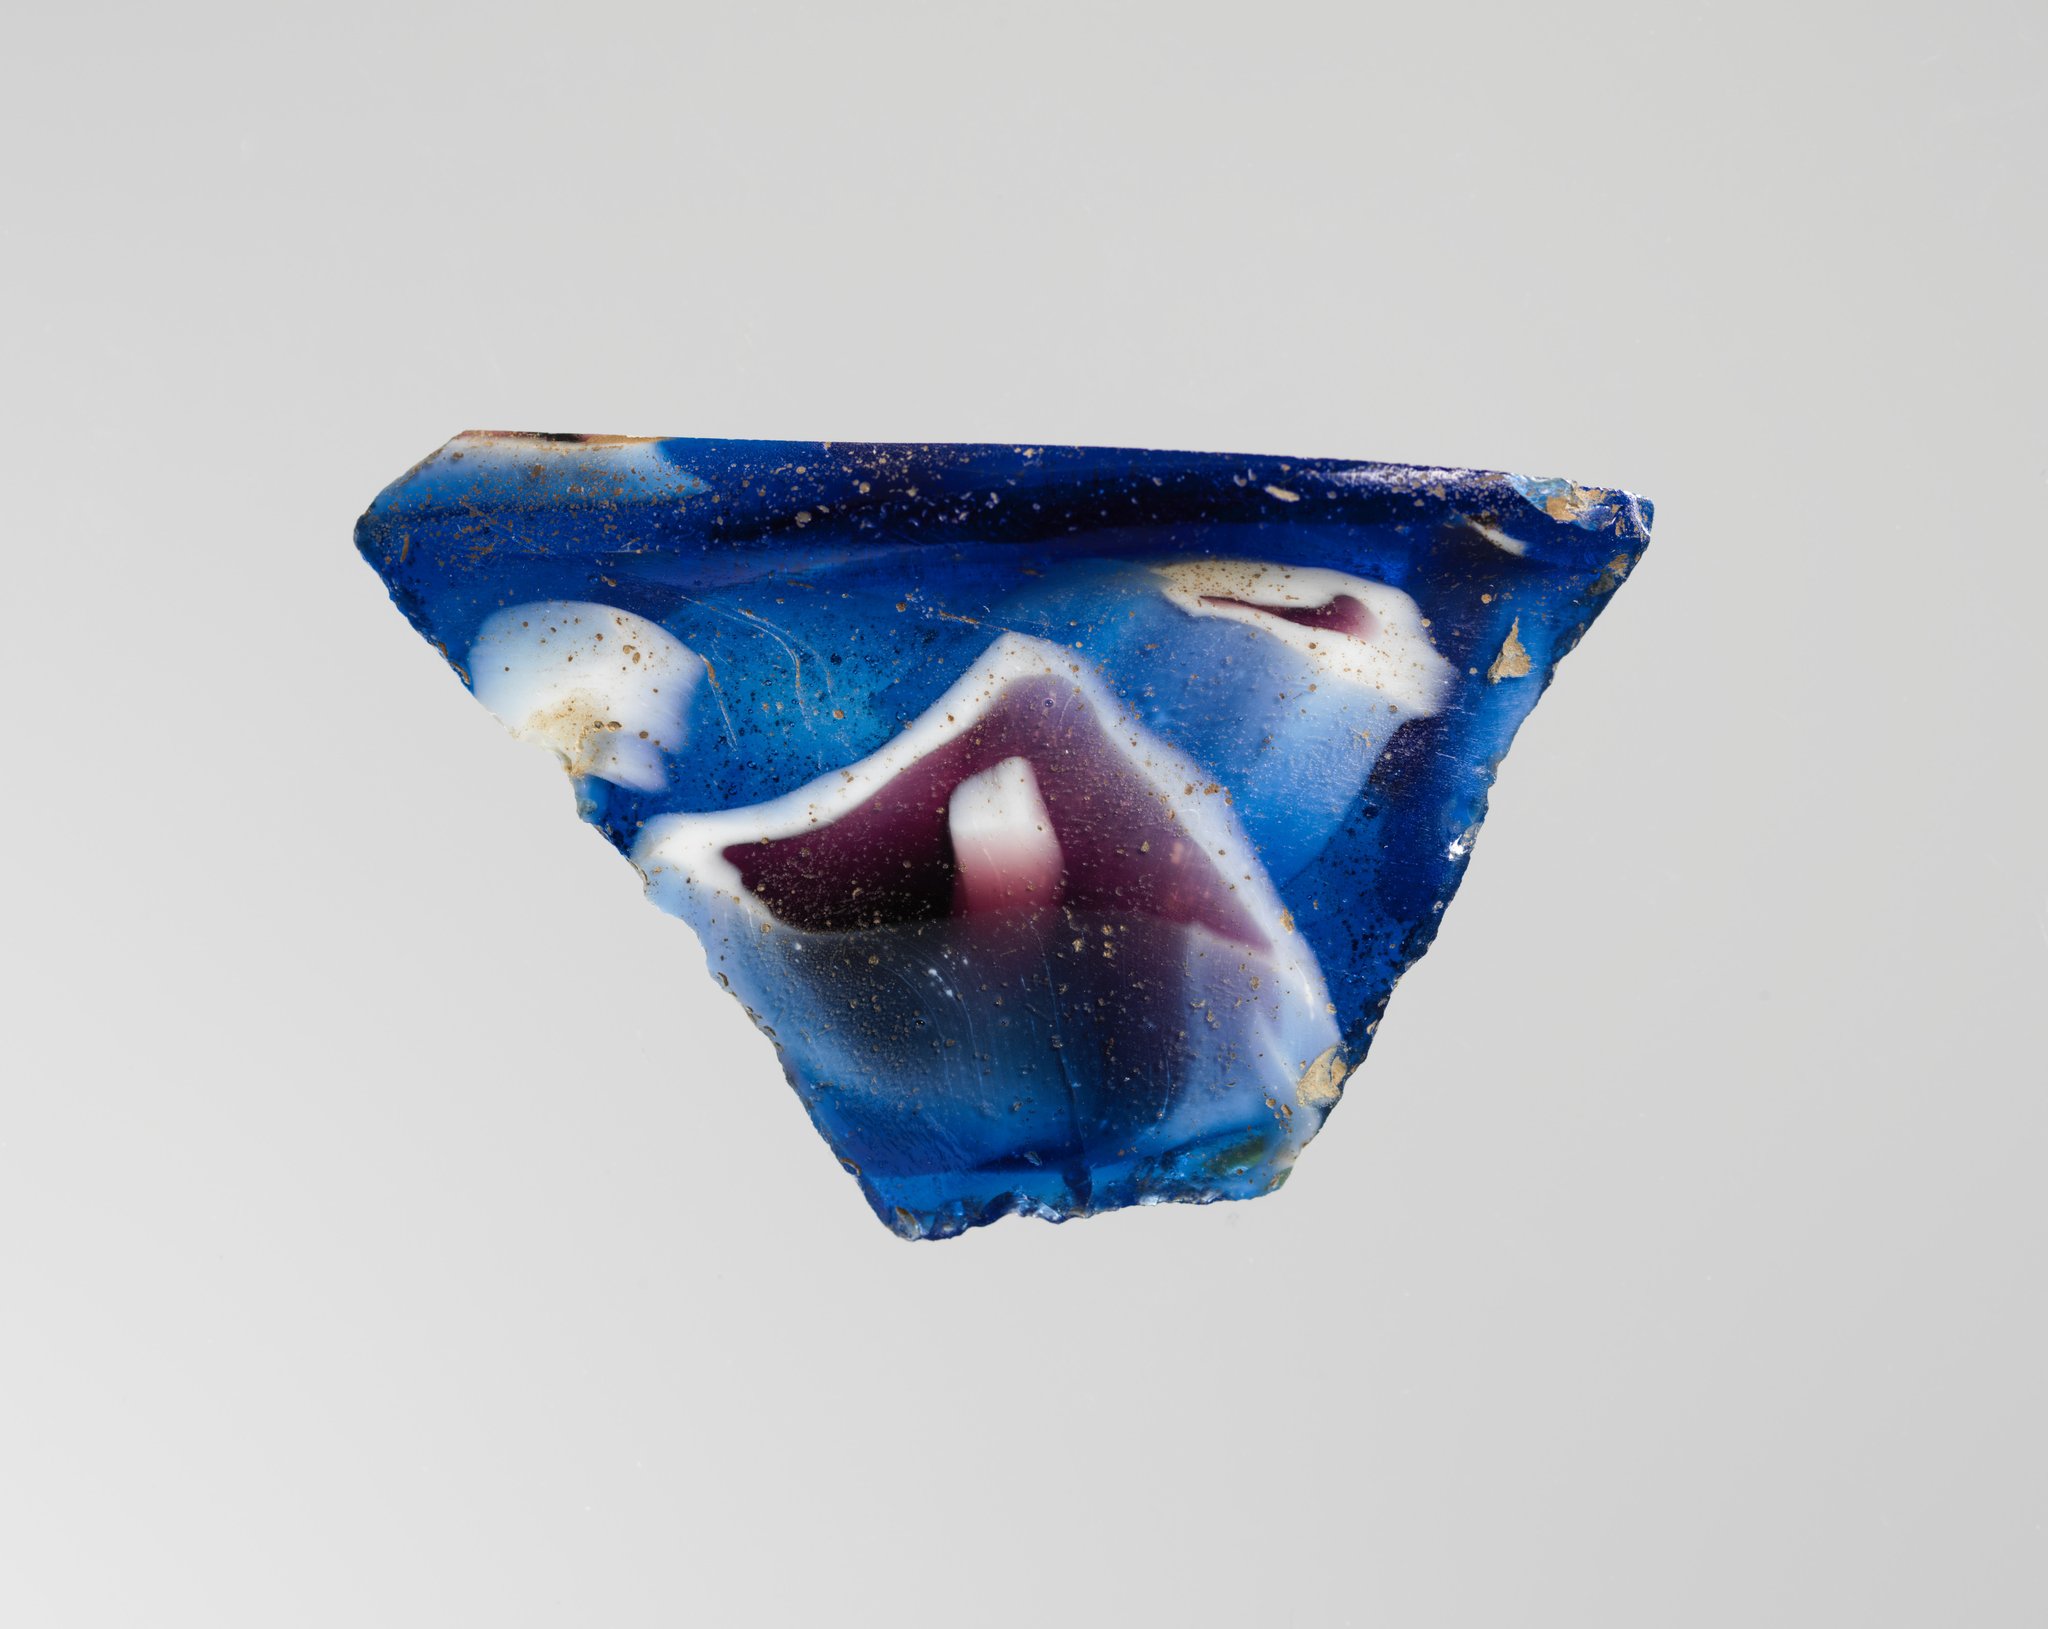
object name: fragment, mosaic bowl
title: Glass mosaic ribbed bowl fragment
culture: roman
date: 34 BCE-33 CE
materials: glass